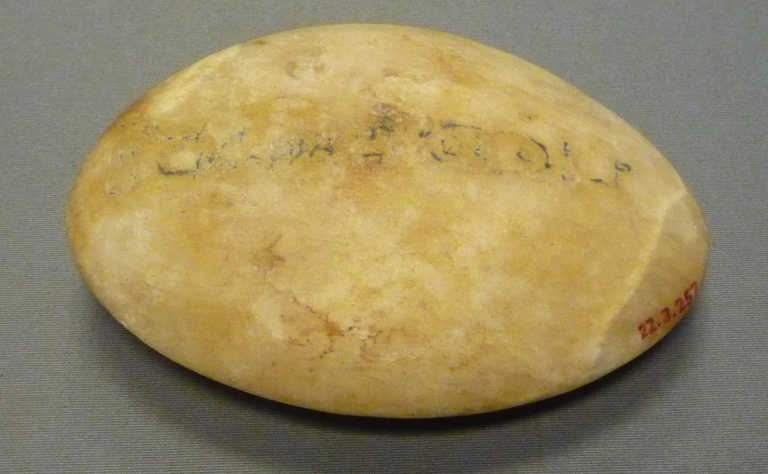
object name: polishing stone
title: Polishing Stone from a Foundation Deposit for Hatshepsut's Temple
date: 1479-1458 BCE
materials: stone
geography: egypt